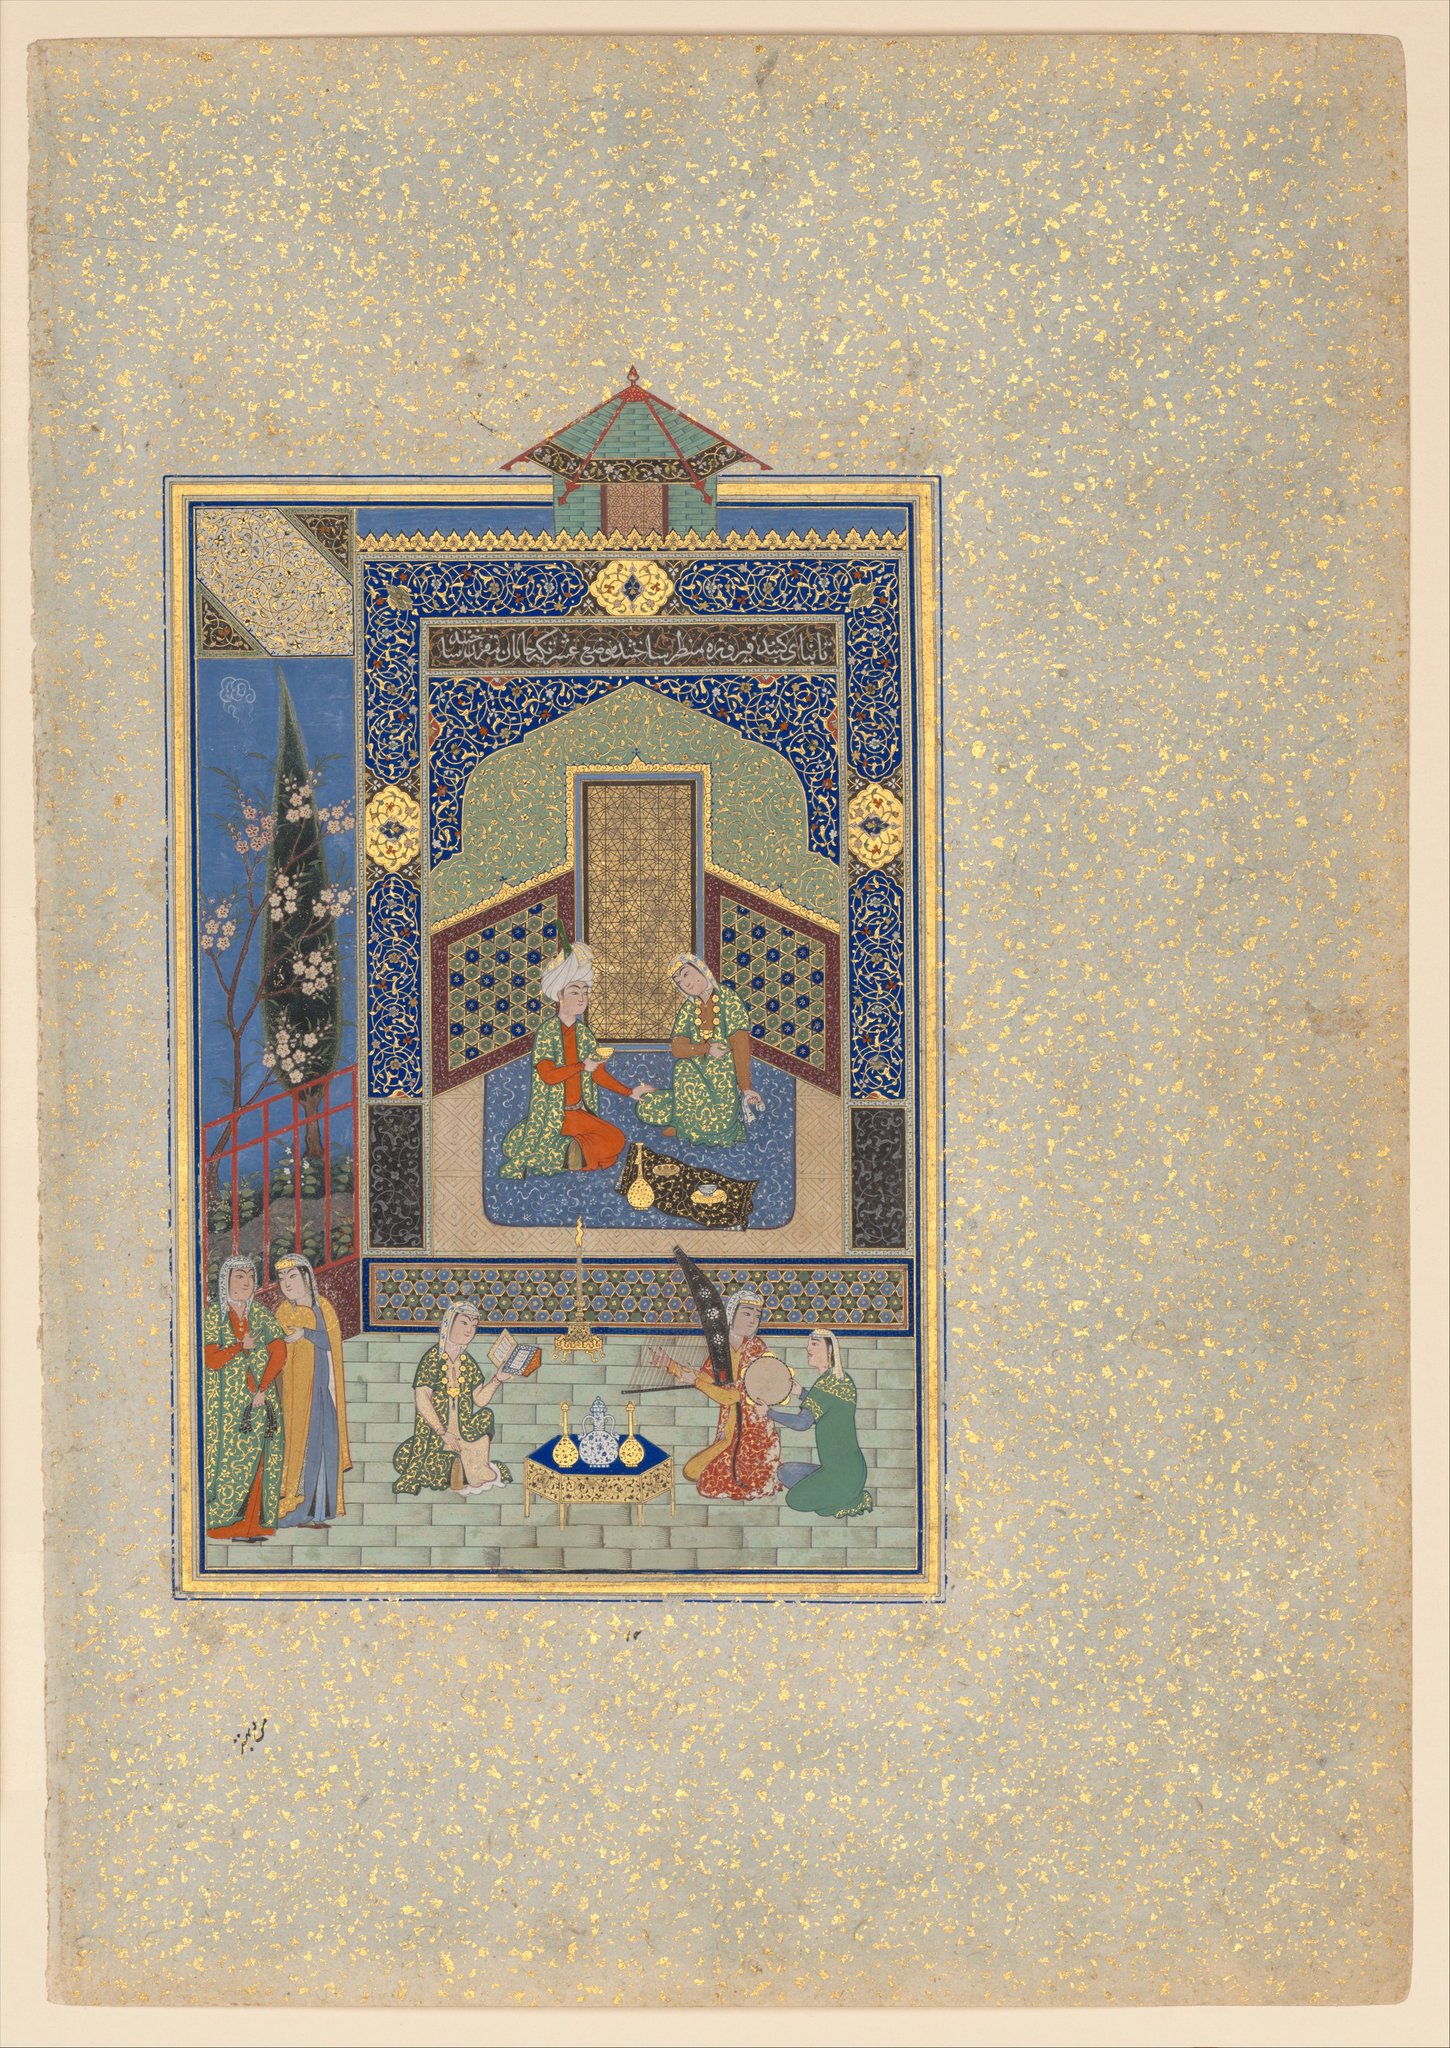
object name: folio from an illustrated manuscript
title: "Bahram Gur in the Turquoise Palace on Wednesday", Folio 216 from a Khamsa (Quintet) of Nizami of Ganja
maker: nizami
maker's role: author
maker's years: 1141-1209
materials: gold, ink, paper, silver, watercolor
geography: afghanistan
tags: musical instruments,men,women,musicians